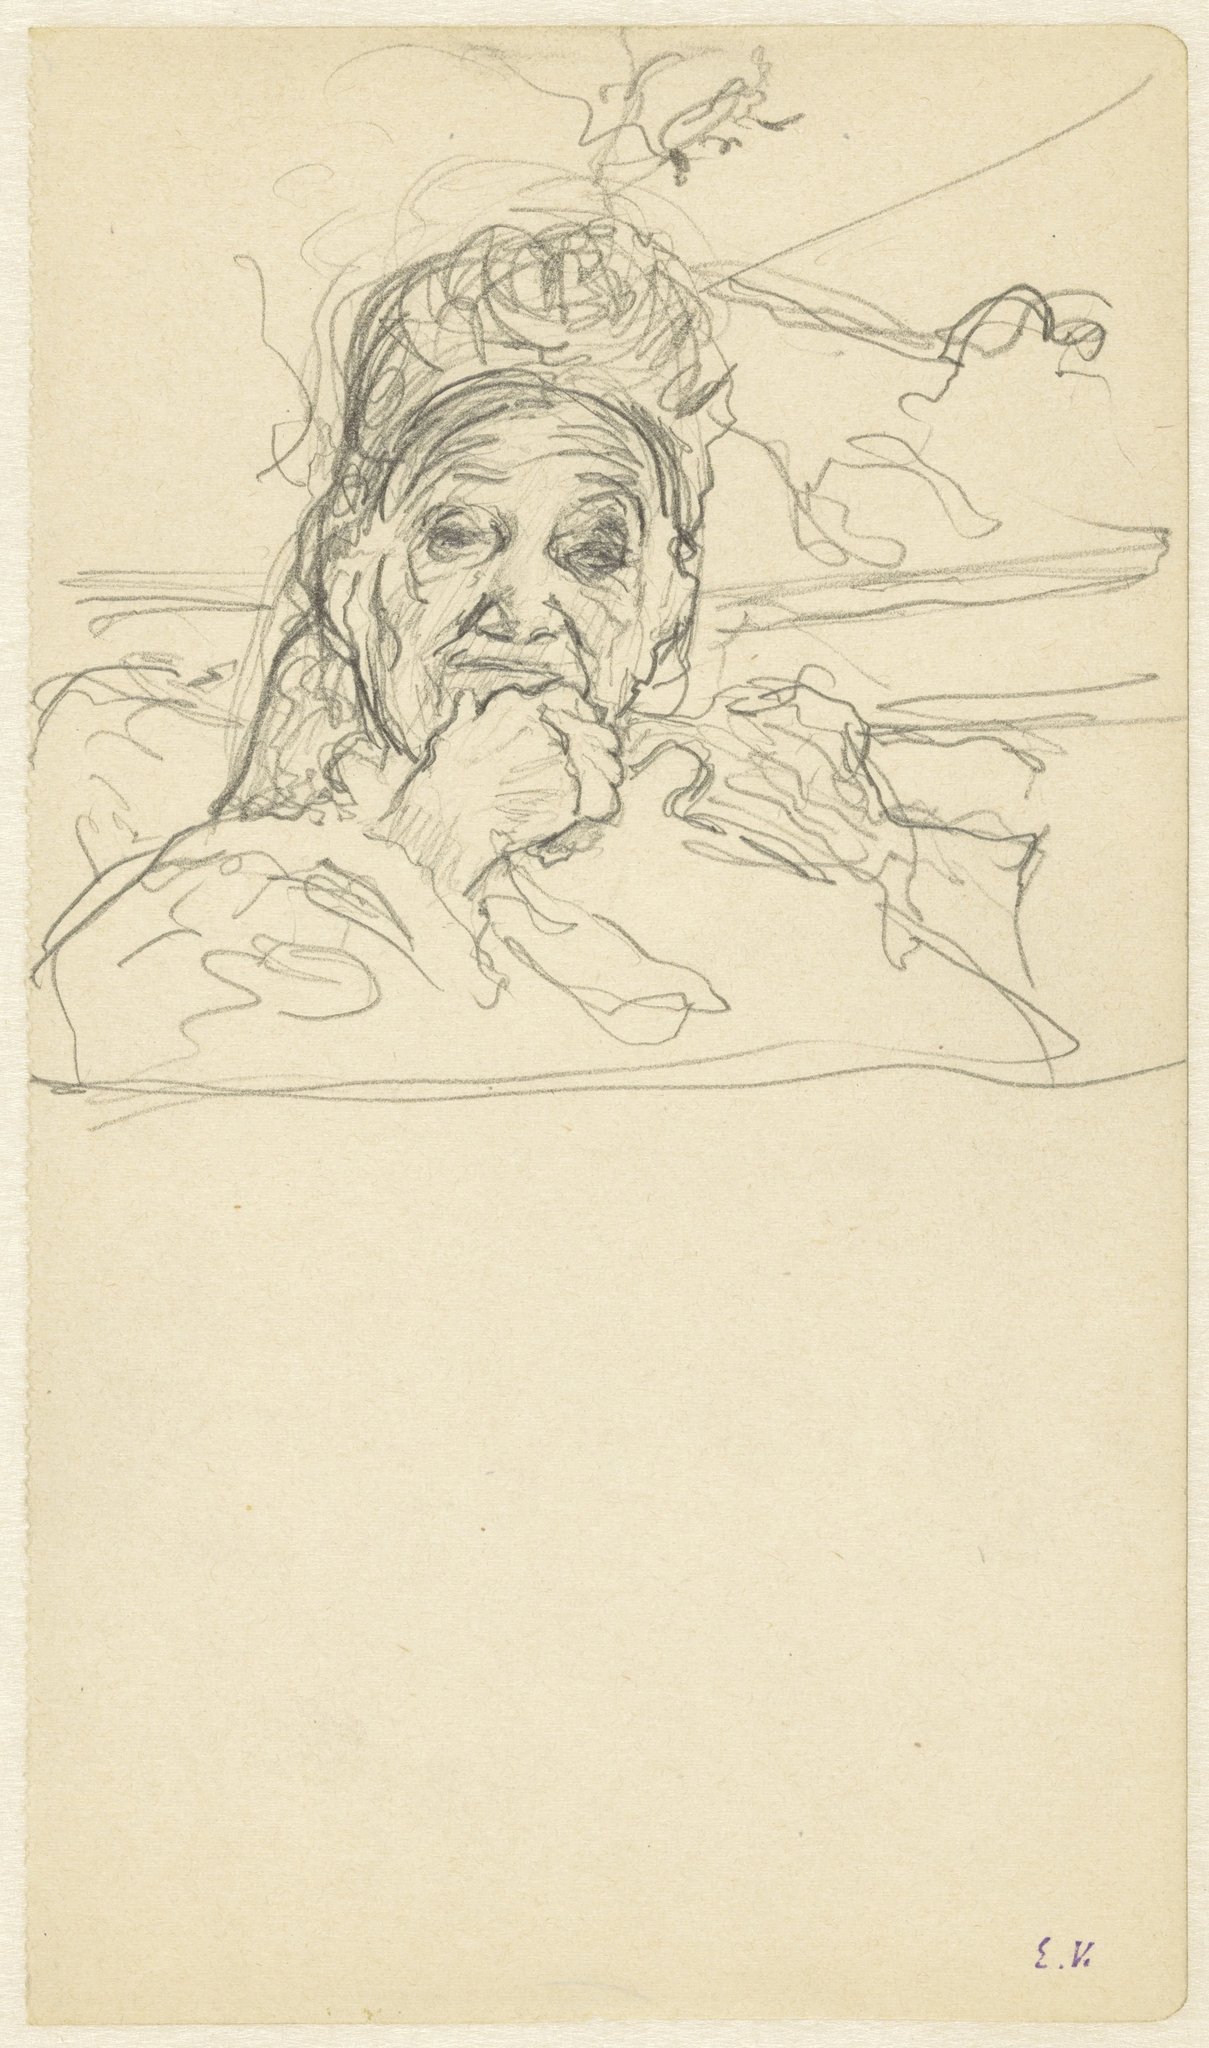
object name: drawing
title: De grootmoeder, portret tot op de schouders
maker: édouard vuillard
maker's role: draughtsman, print maker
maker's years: 1868-1940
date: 1878-1940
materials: paper, pencil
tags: historical persons not known by name - bb - woman, old woman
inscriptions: inscription: ‘La Grand-Mère’